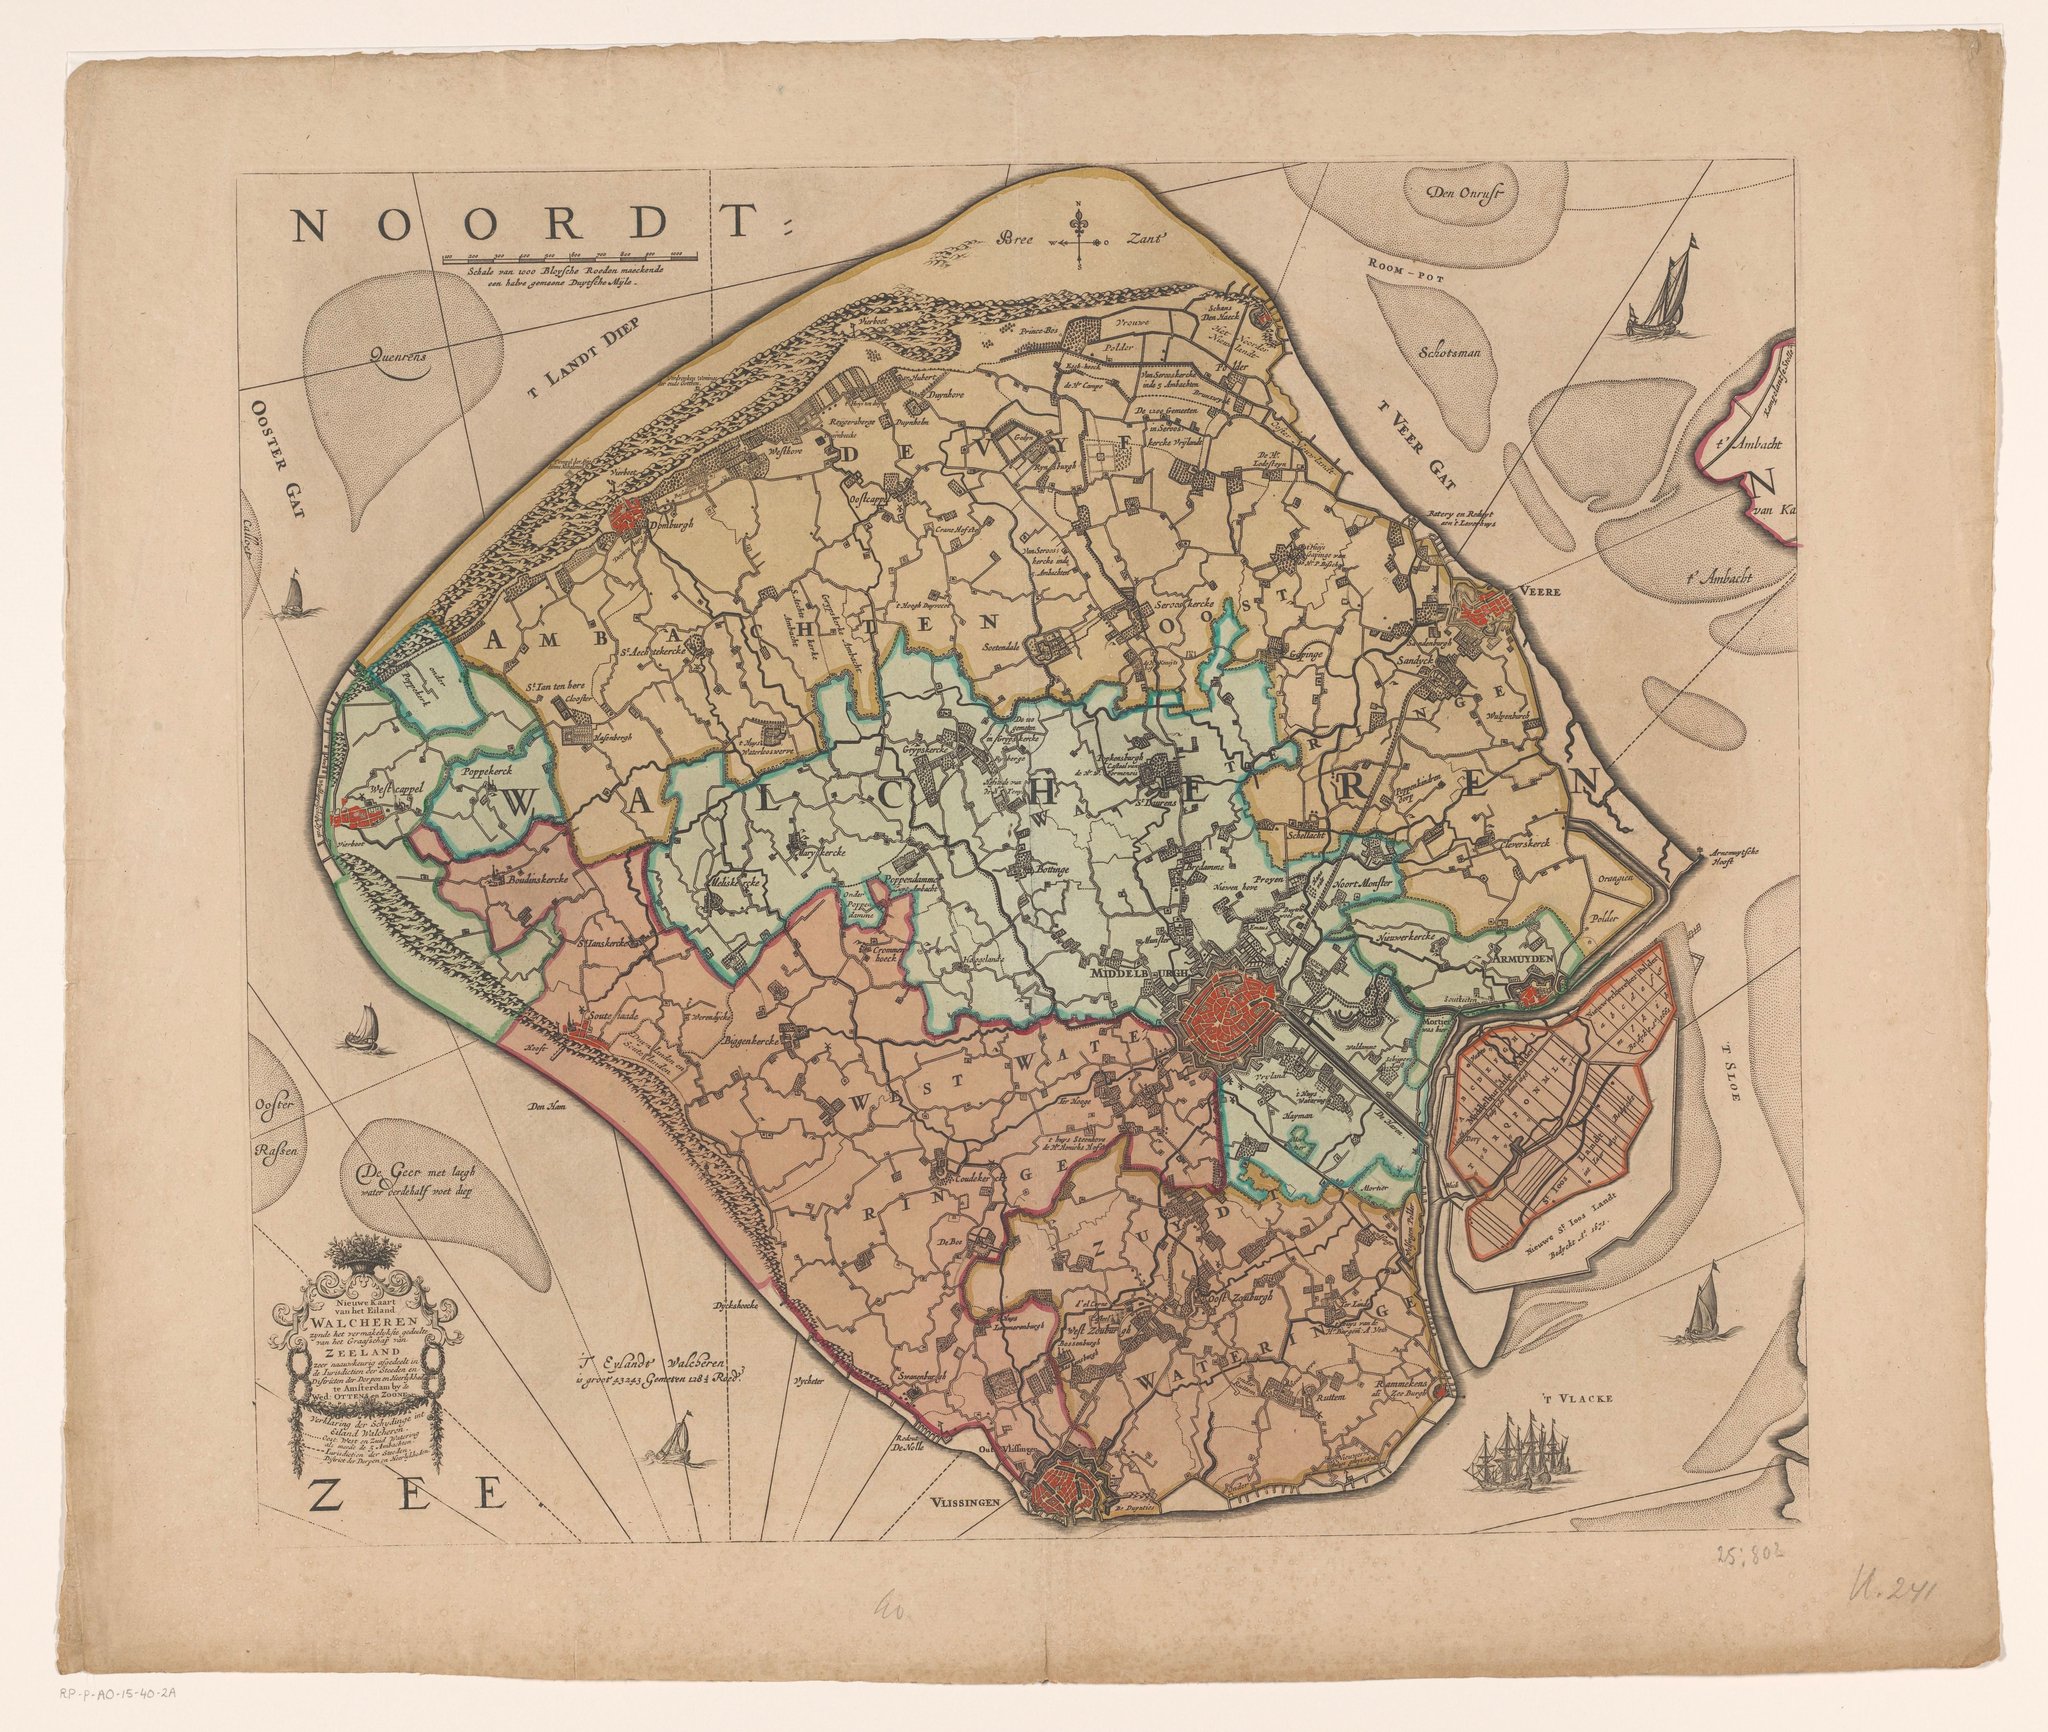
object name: print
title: Nieuwe Kaart van het Eiland Walcheren zynde het vermakelykste gedeelte in het Graafschap van Zeeland zeer naauwkeurig afgedeelt in de Iurisdictien der Steeden en Districten der Dorpen en Heerlykheden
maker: Anonymous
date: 1655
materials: paper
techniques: engraving, etching, hand coloring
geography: amsterdam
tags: maps of separate countries or regions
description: Zie ook RP-P-AO-15-38A, RP-P-AO-15-39 en RP-P-AO-15-40-2B. Deze kaart komt ook voor als onderdeel van de zogenaamde Visscher-Romankaart, een wandkaart van Zeeland. Zie RP-P-AO-15-13, RP-P-AO-15-13B en documentatie voor meer informatie.